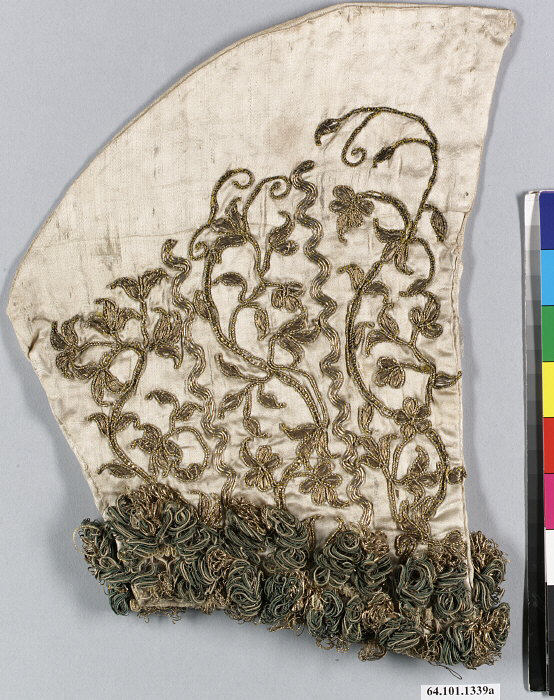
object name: dress sleeve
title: Pair of short dress sleeves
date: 1700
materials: metal thread, textile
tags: flowers